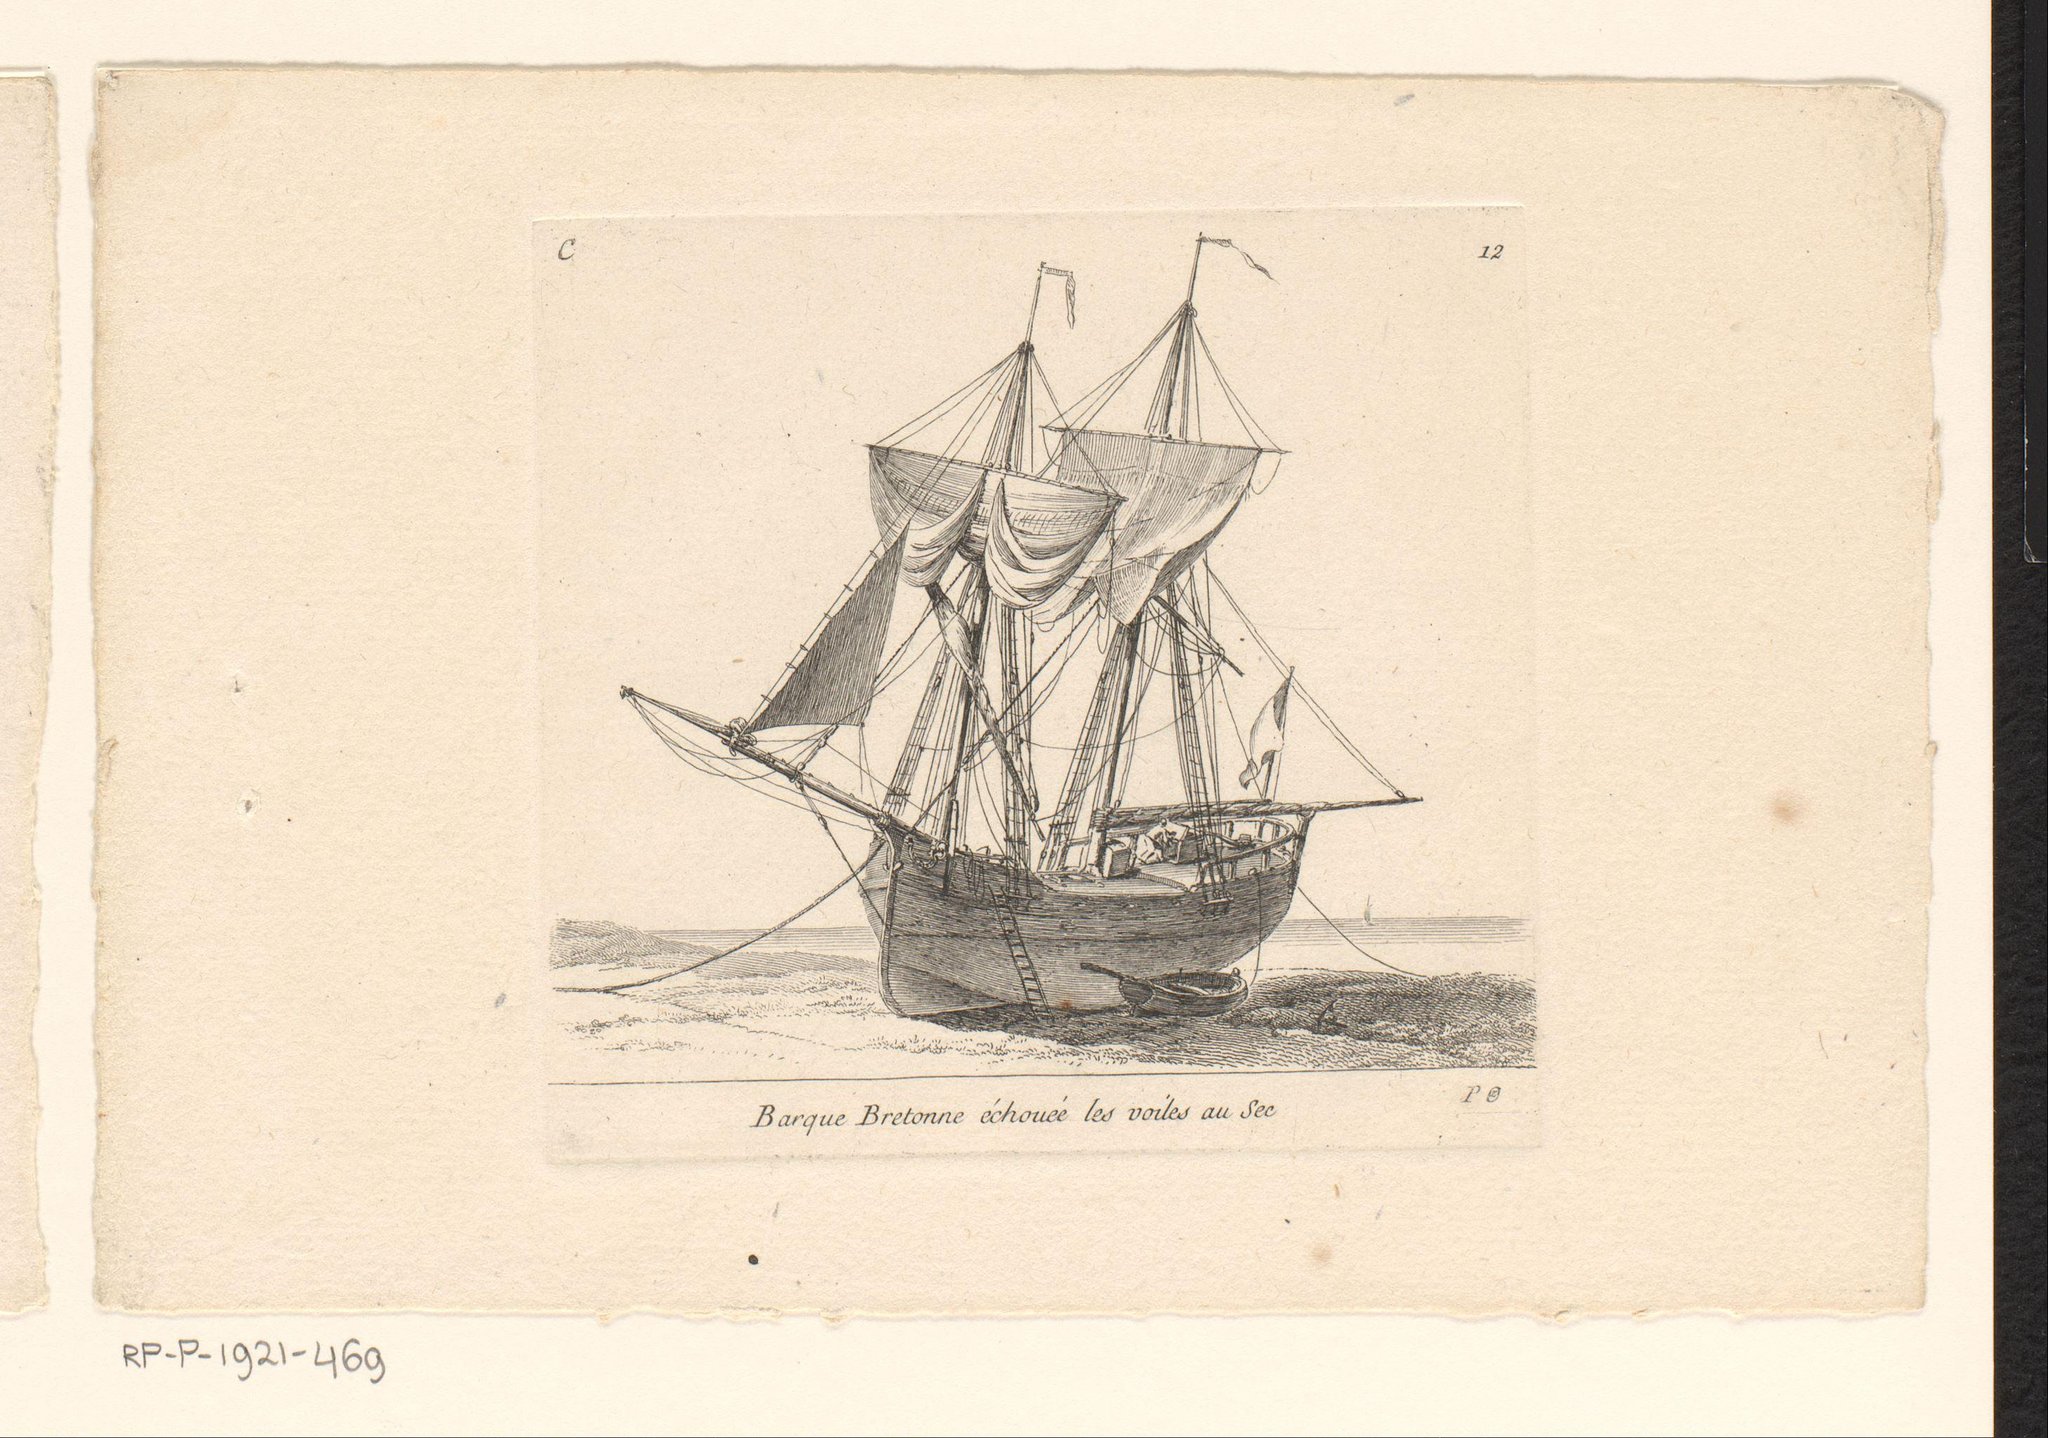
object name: print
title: Derde collectie schepen en boten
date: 1747-1813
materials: paper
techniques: etching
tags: ships, boats on land, beached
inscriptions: collector's mark: Lugt 2233